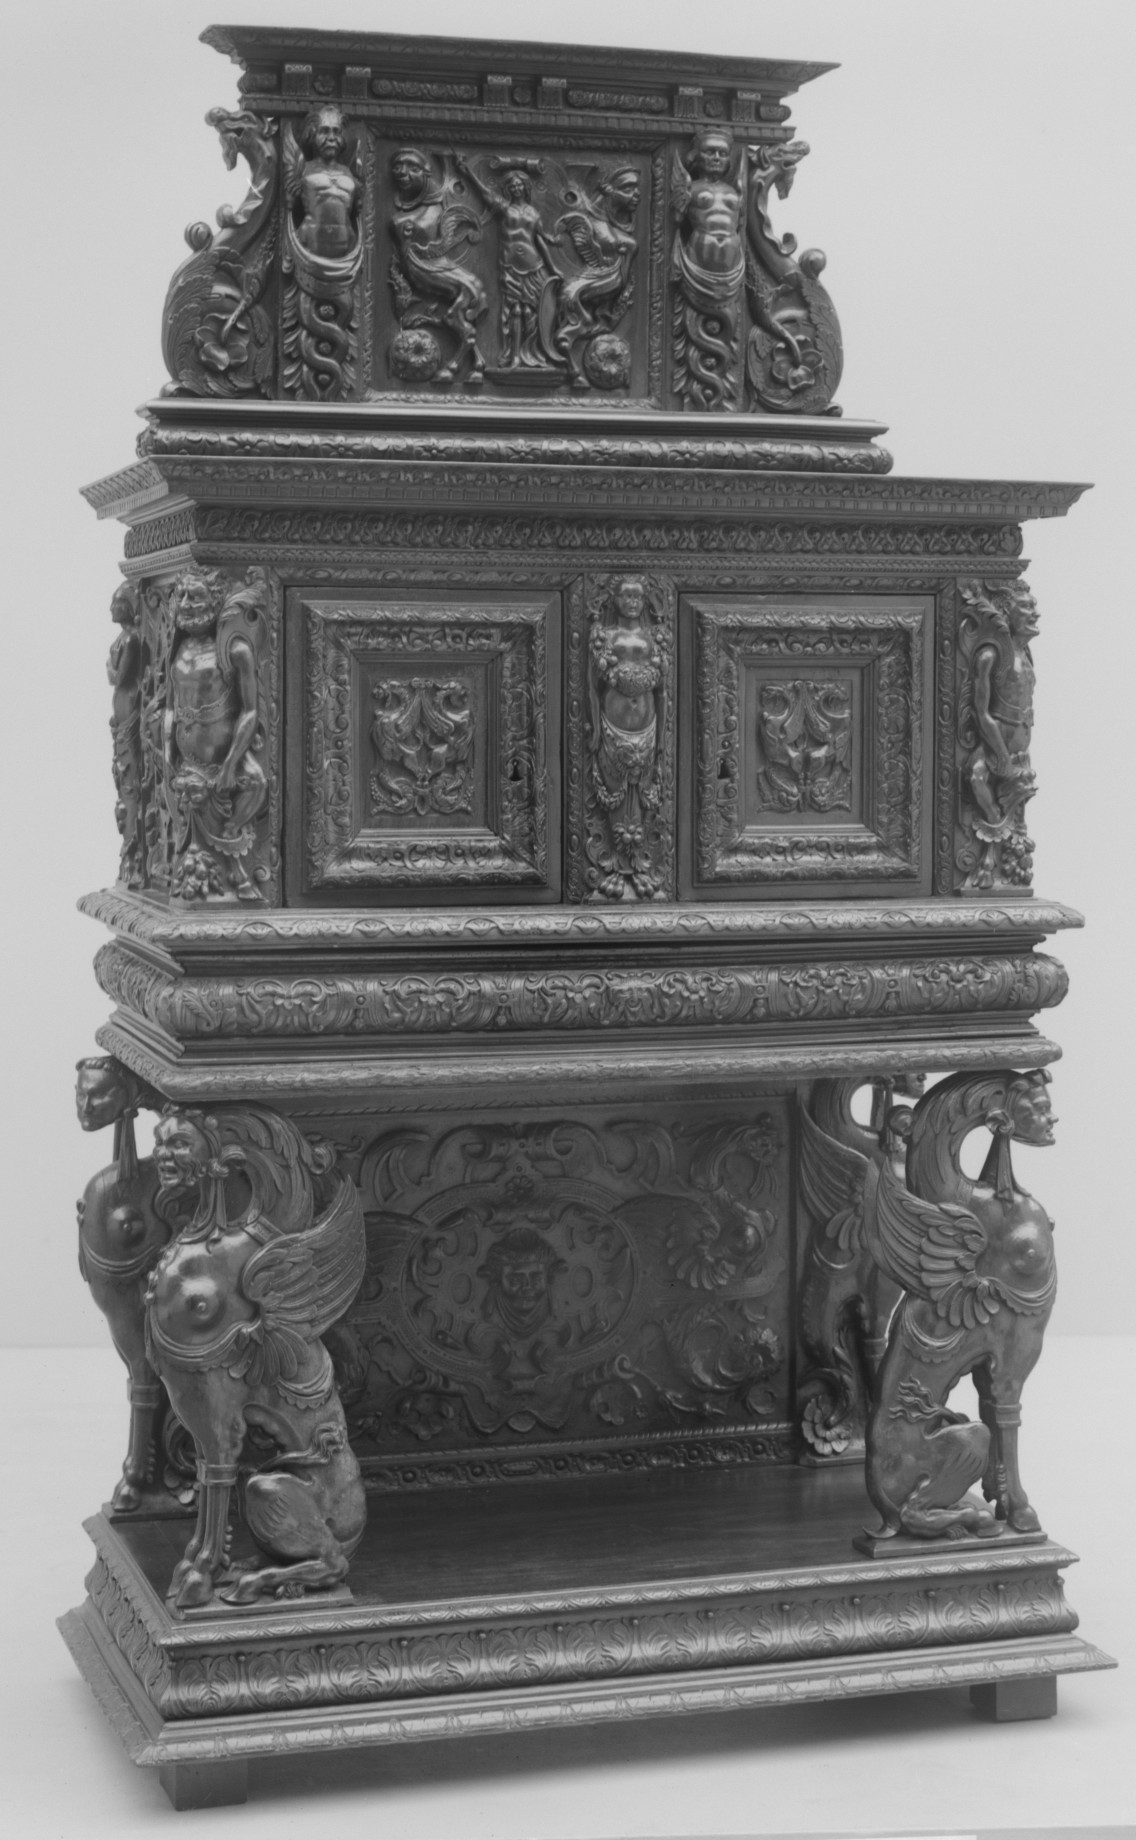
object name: cabinet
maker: hugues sambin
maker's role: maker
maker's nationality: french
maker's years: 1520-1601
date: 1801-1900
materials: wood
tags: sphinx,satyrs